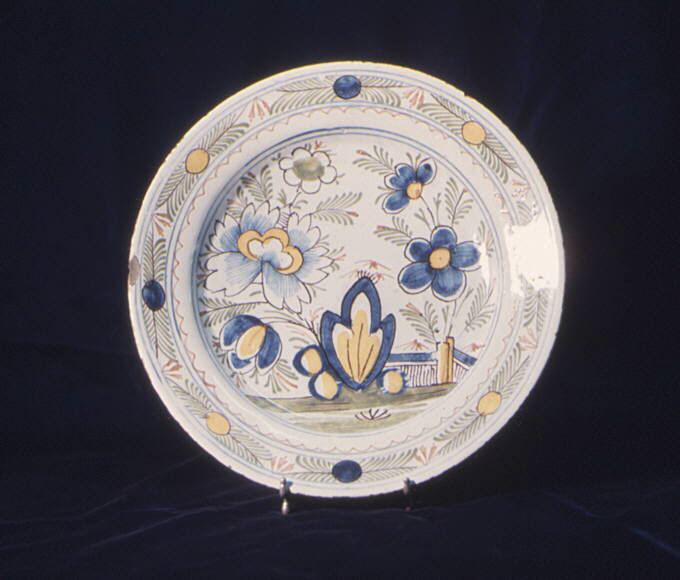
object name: plate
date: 1767-1800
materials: earthenware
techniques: glazing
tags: flowers